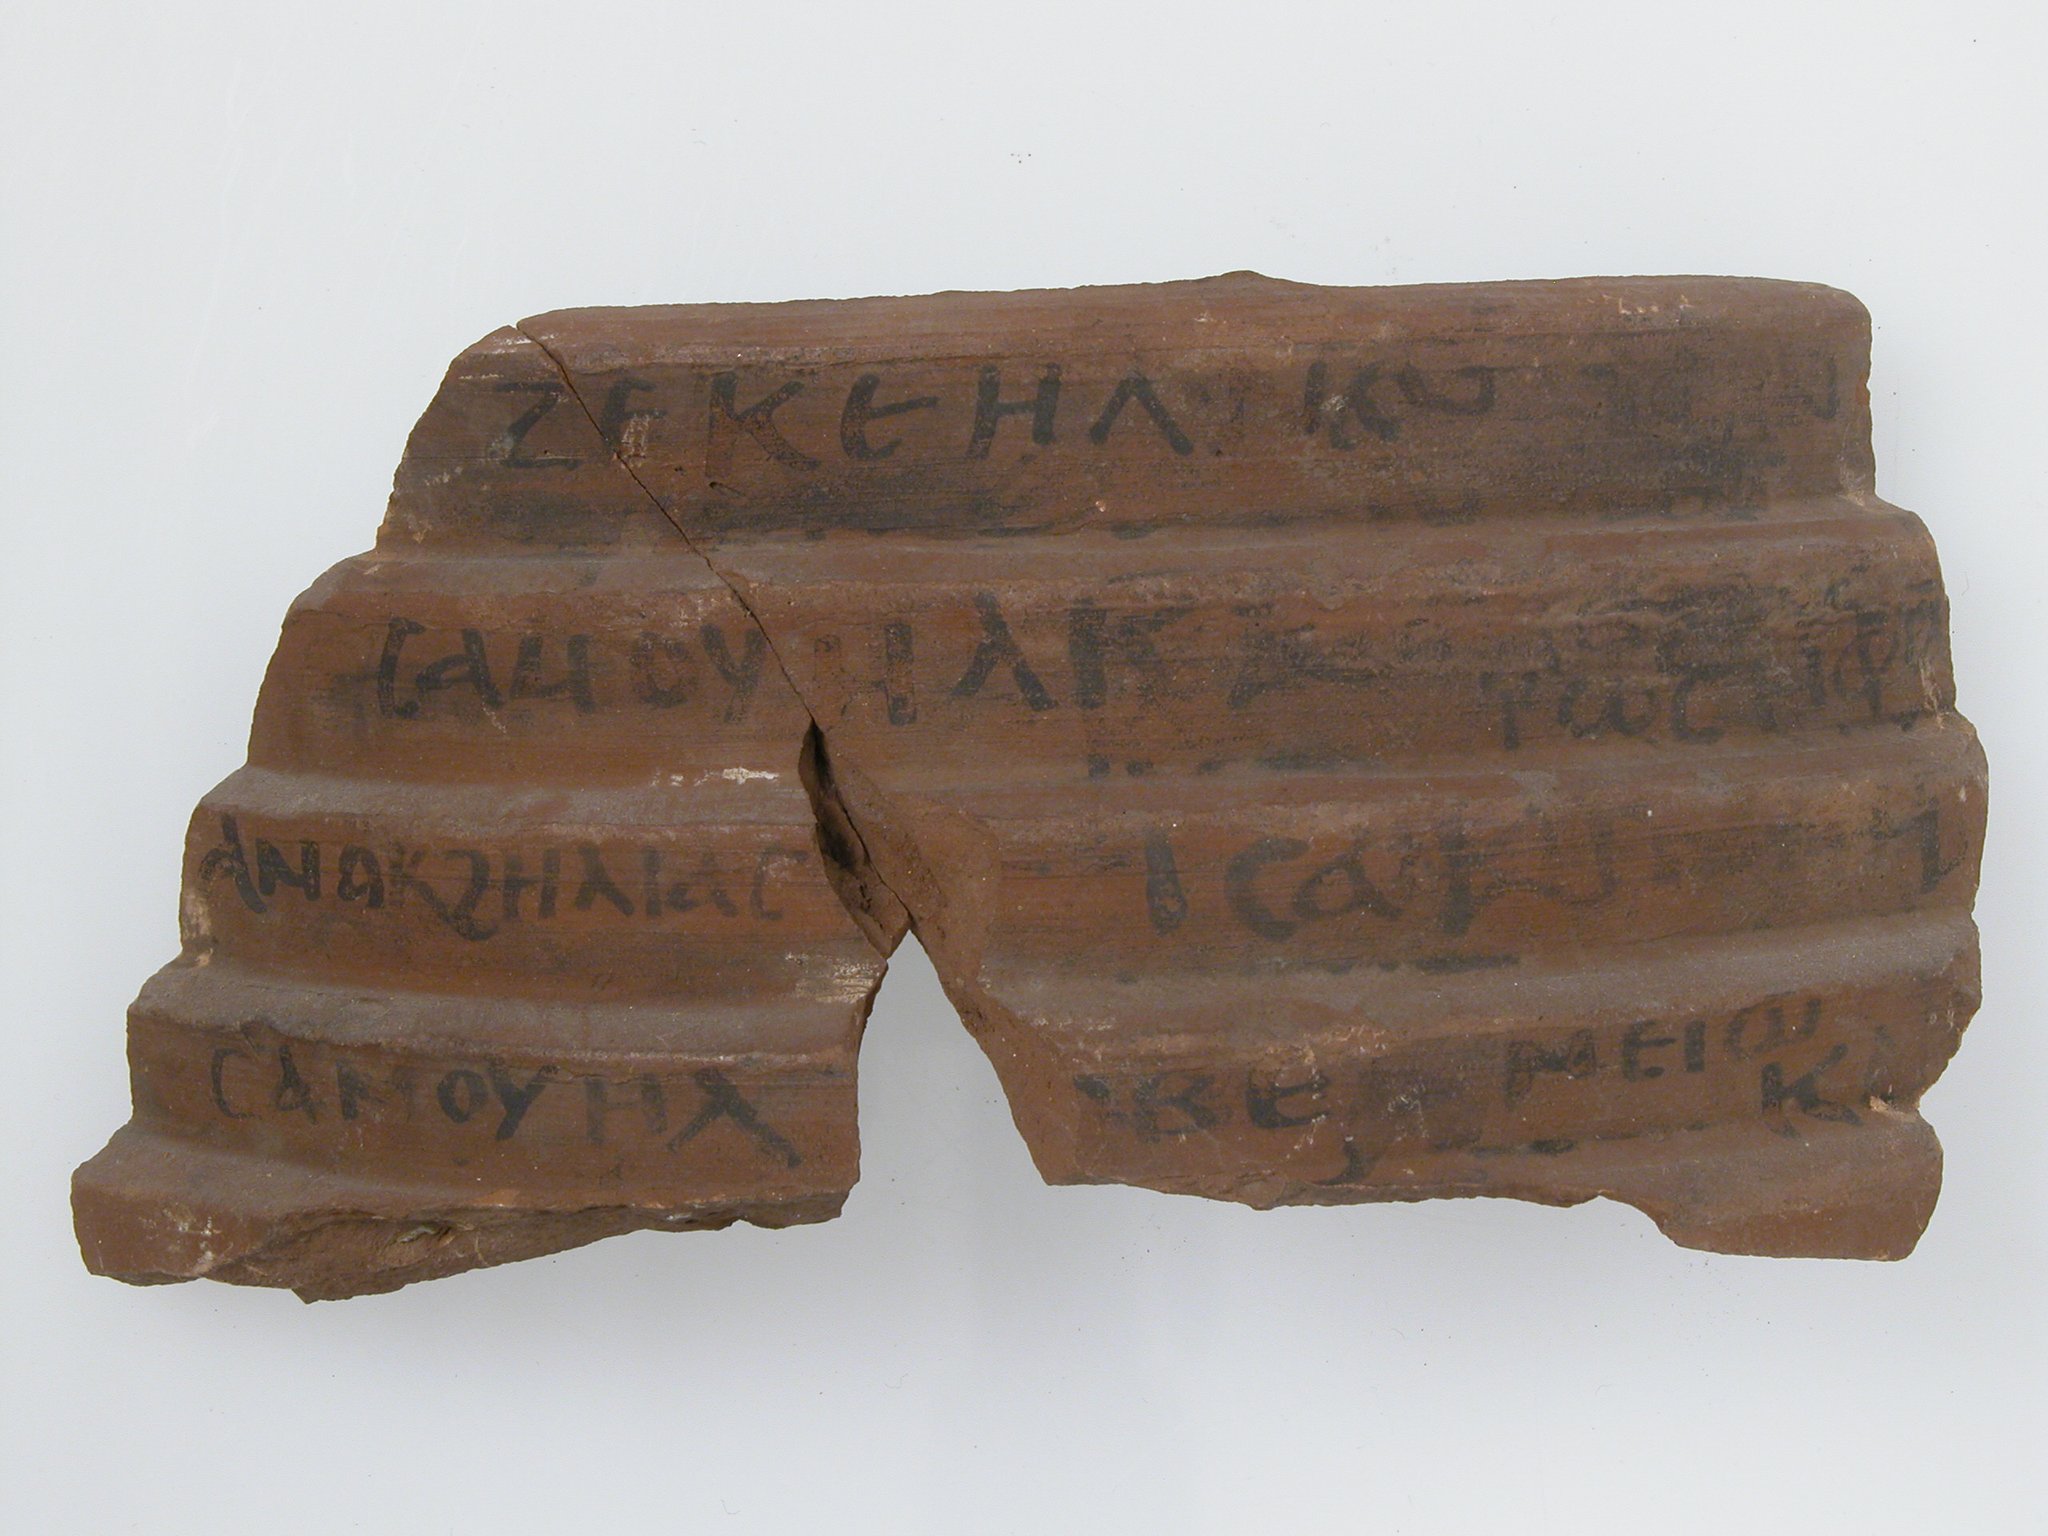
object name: ostrakon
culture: coptic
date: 601-700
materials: ink, pottery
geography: egypt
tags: coptic,documents